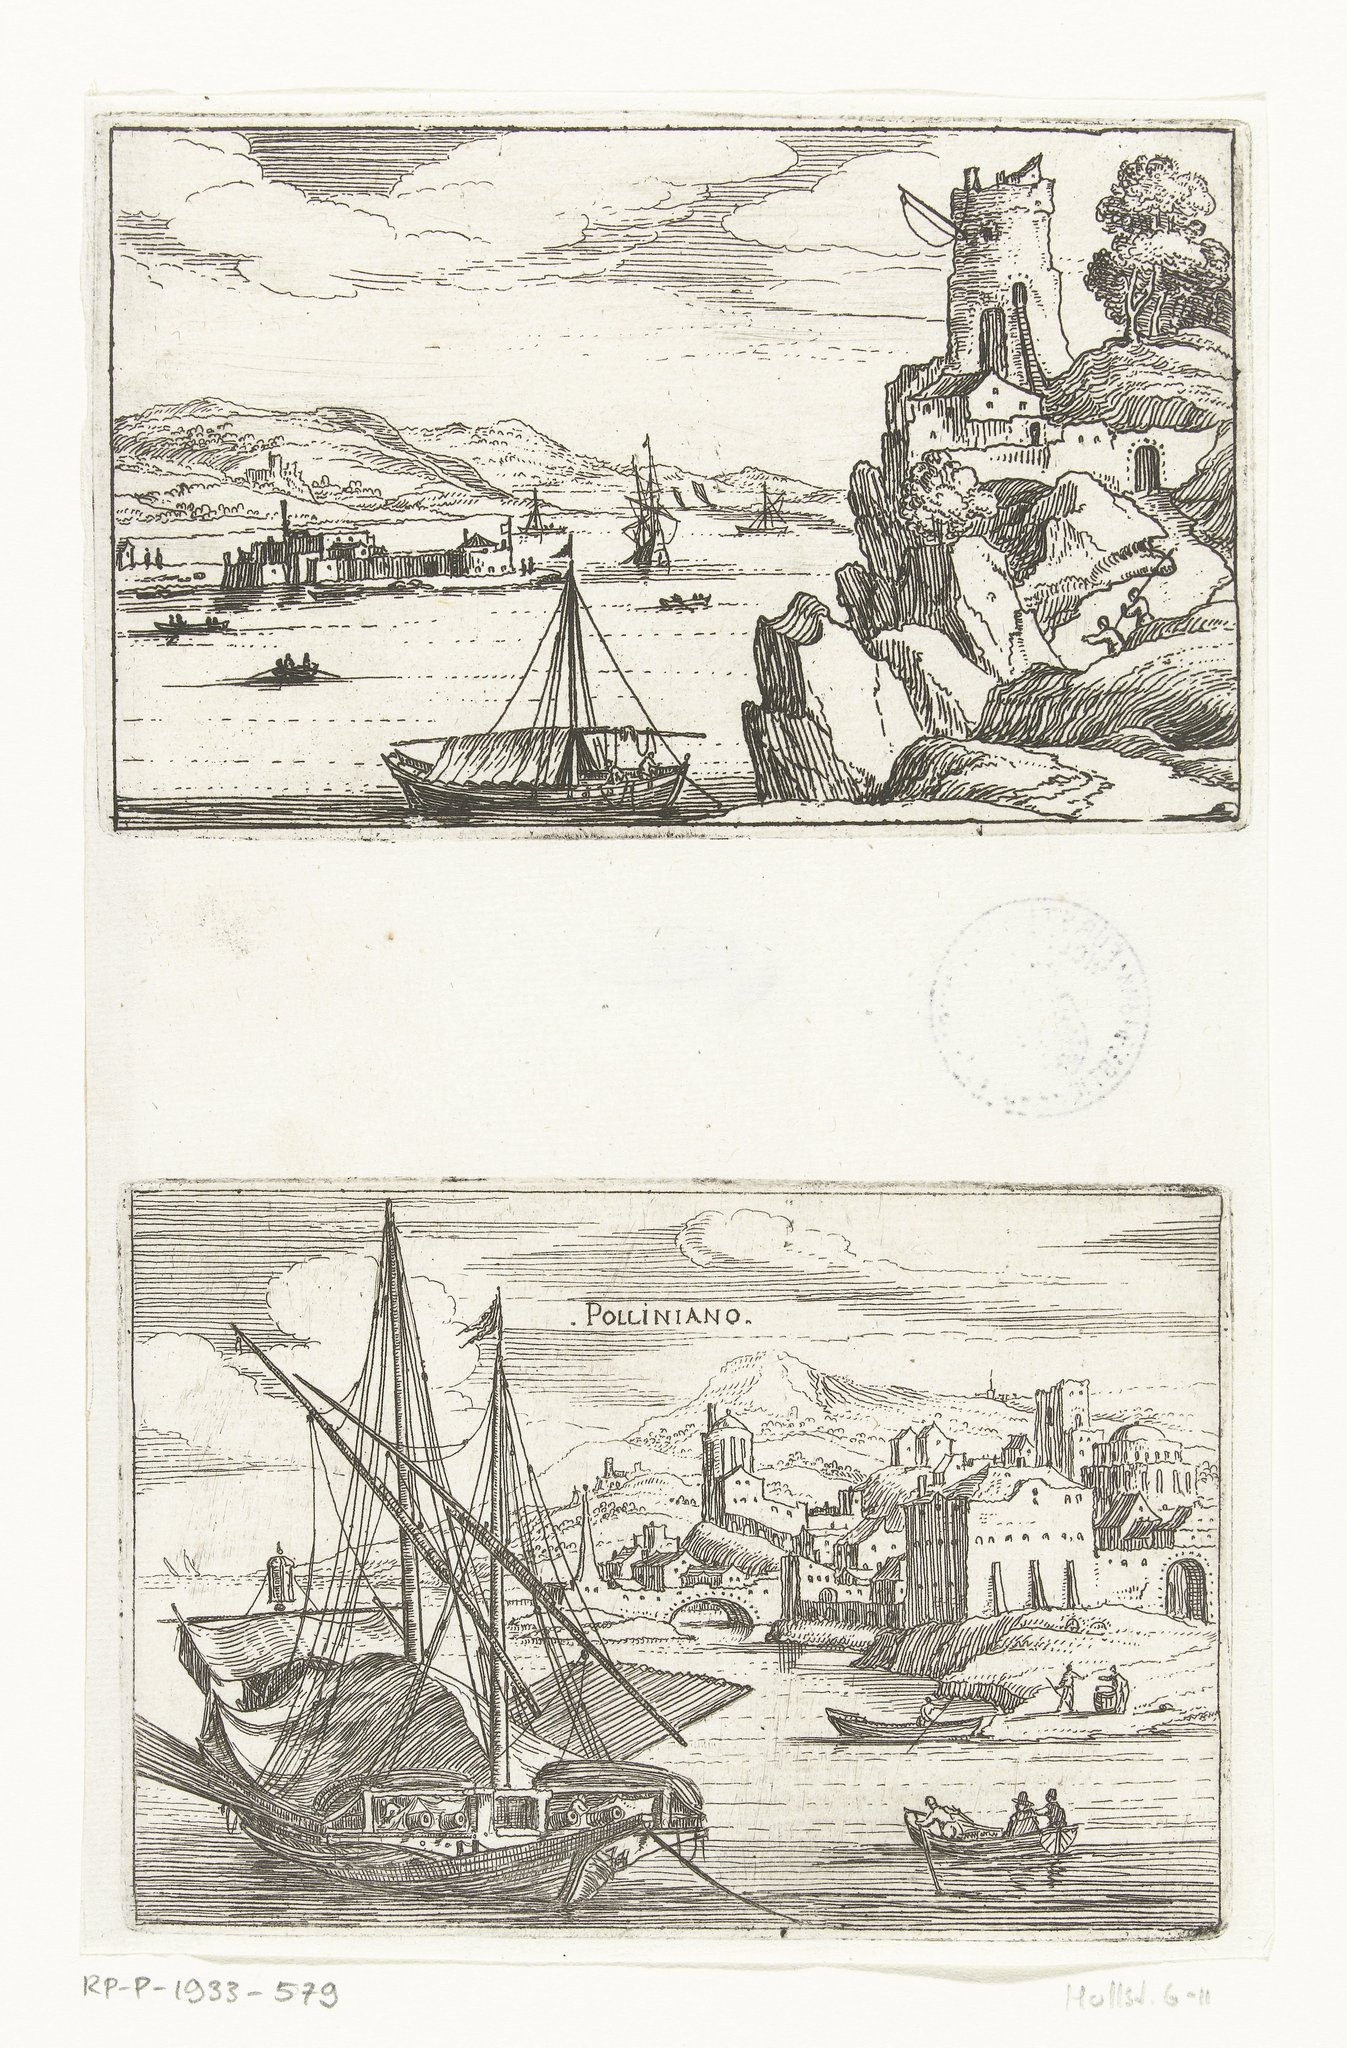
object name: print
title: Polliniano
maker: cornelis bol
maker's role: print maker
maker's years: 1589-1666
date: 1615-1666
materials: paper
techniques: etching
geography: netherlands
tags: harbour, prospect of city, town panorama, silhouette of city, polignano a mare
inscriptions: collector's mark: Lugt 2228, collector's mark: Lugt 2542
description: Twee platen afgedrukt op een vel papier. Boven een baai met aan de kust op een rots een toren. In de baai varen schepen en roeiboten. Onder een gezicht op de stad Polignano a Mare in Italië vanuit de zee gezien.